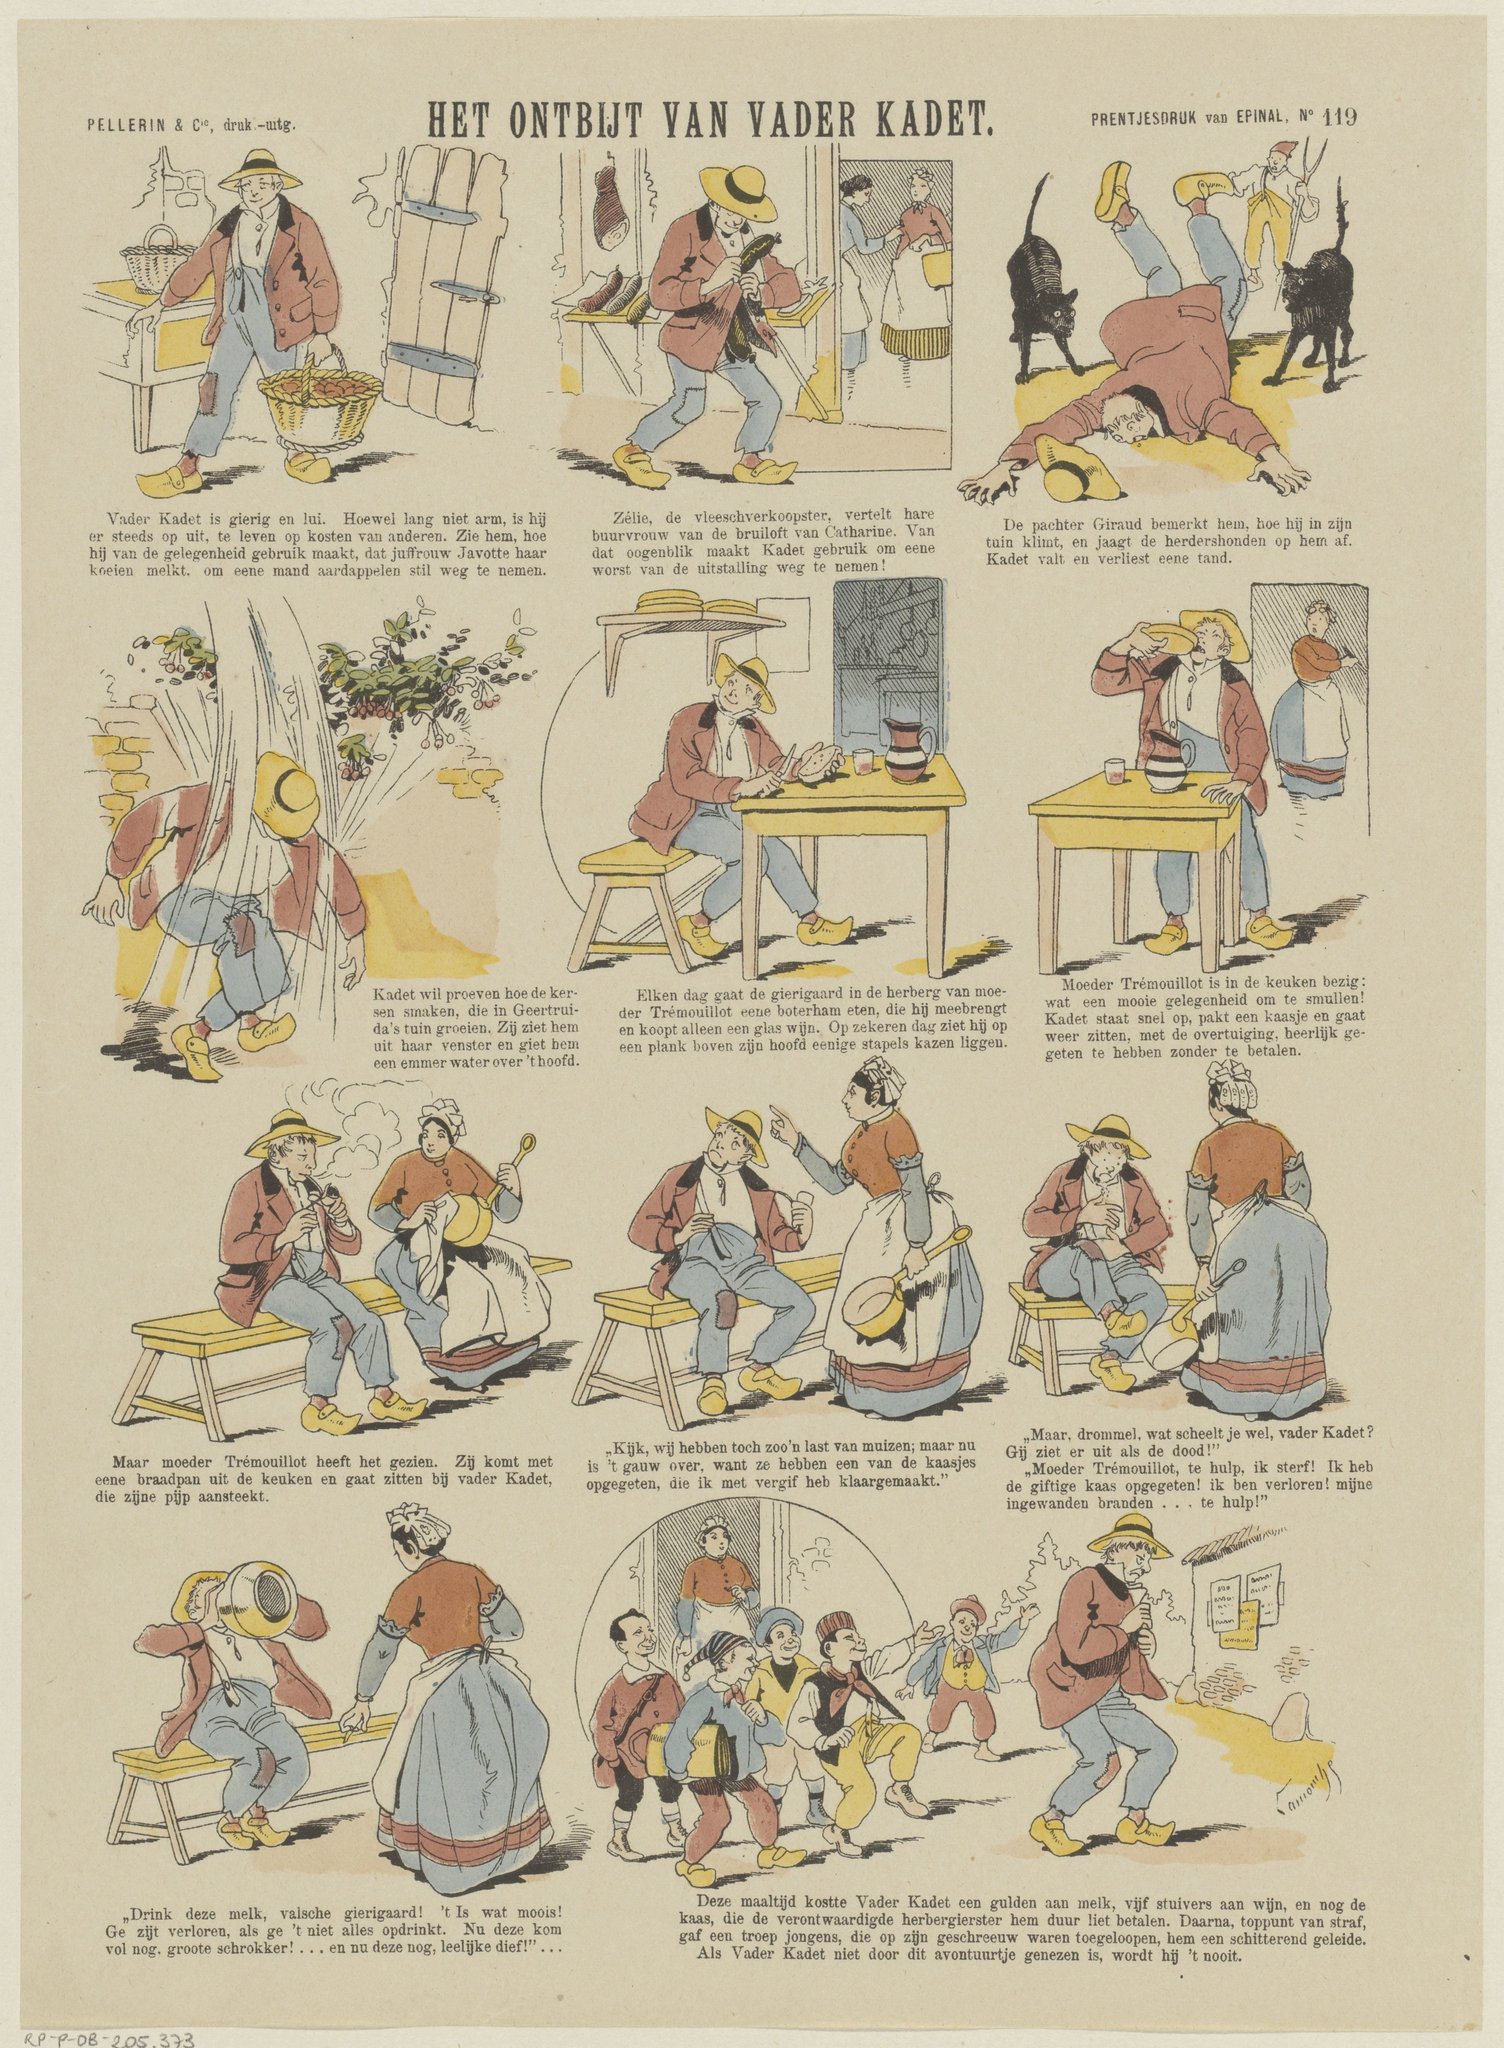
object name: popular print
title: Het ontbijt van vader kadet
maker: camouche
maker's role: print maker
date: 1902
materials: paper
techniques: colour, letterpress printing, lithograph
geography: epinal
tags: bad behaviour, theft, miser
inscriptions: collector's mark: Lugt 2760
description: Blad met 11 voorstellingen over de gierigaard vader Kadet die eten steelt. Onder elke afbeelding een onderschrift. Genummerd rechtsboven: No 119.